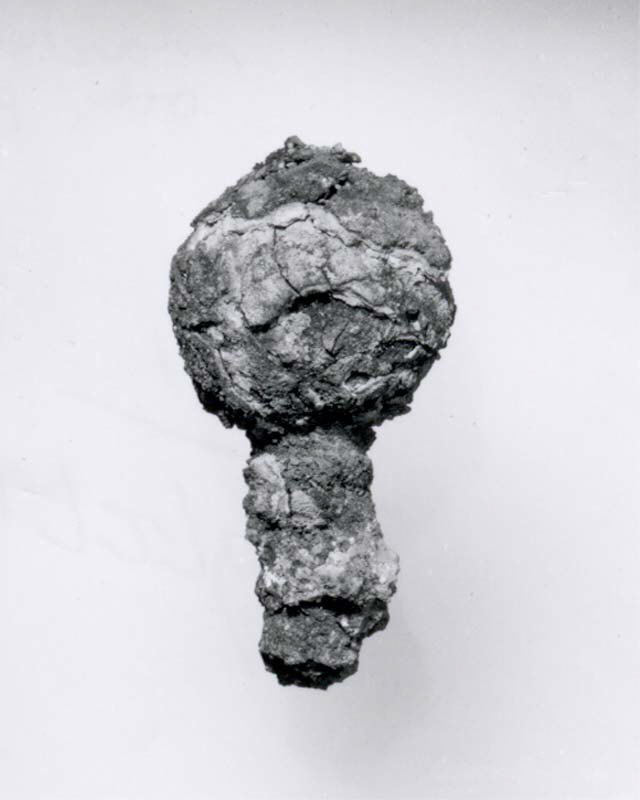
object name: mace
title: Mace head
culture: iranian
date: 900-801 BCE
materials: bronze, copper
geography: iran